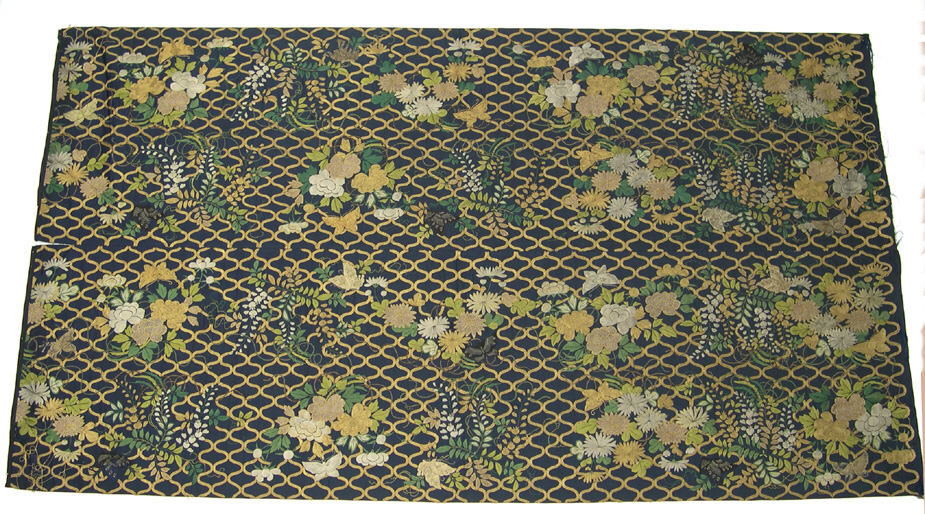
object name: panel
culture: japanese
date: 1701-1900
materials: silk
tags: flowers